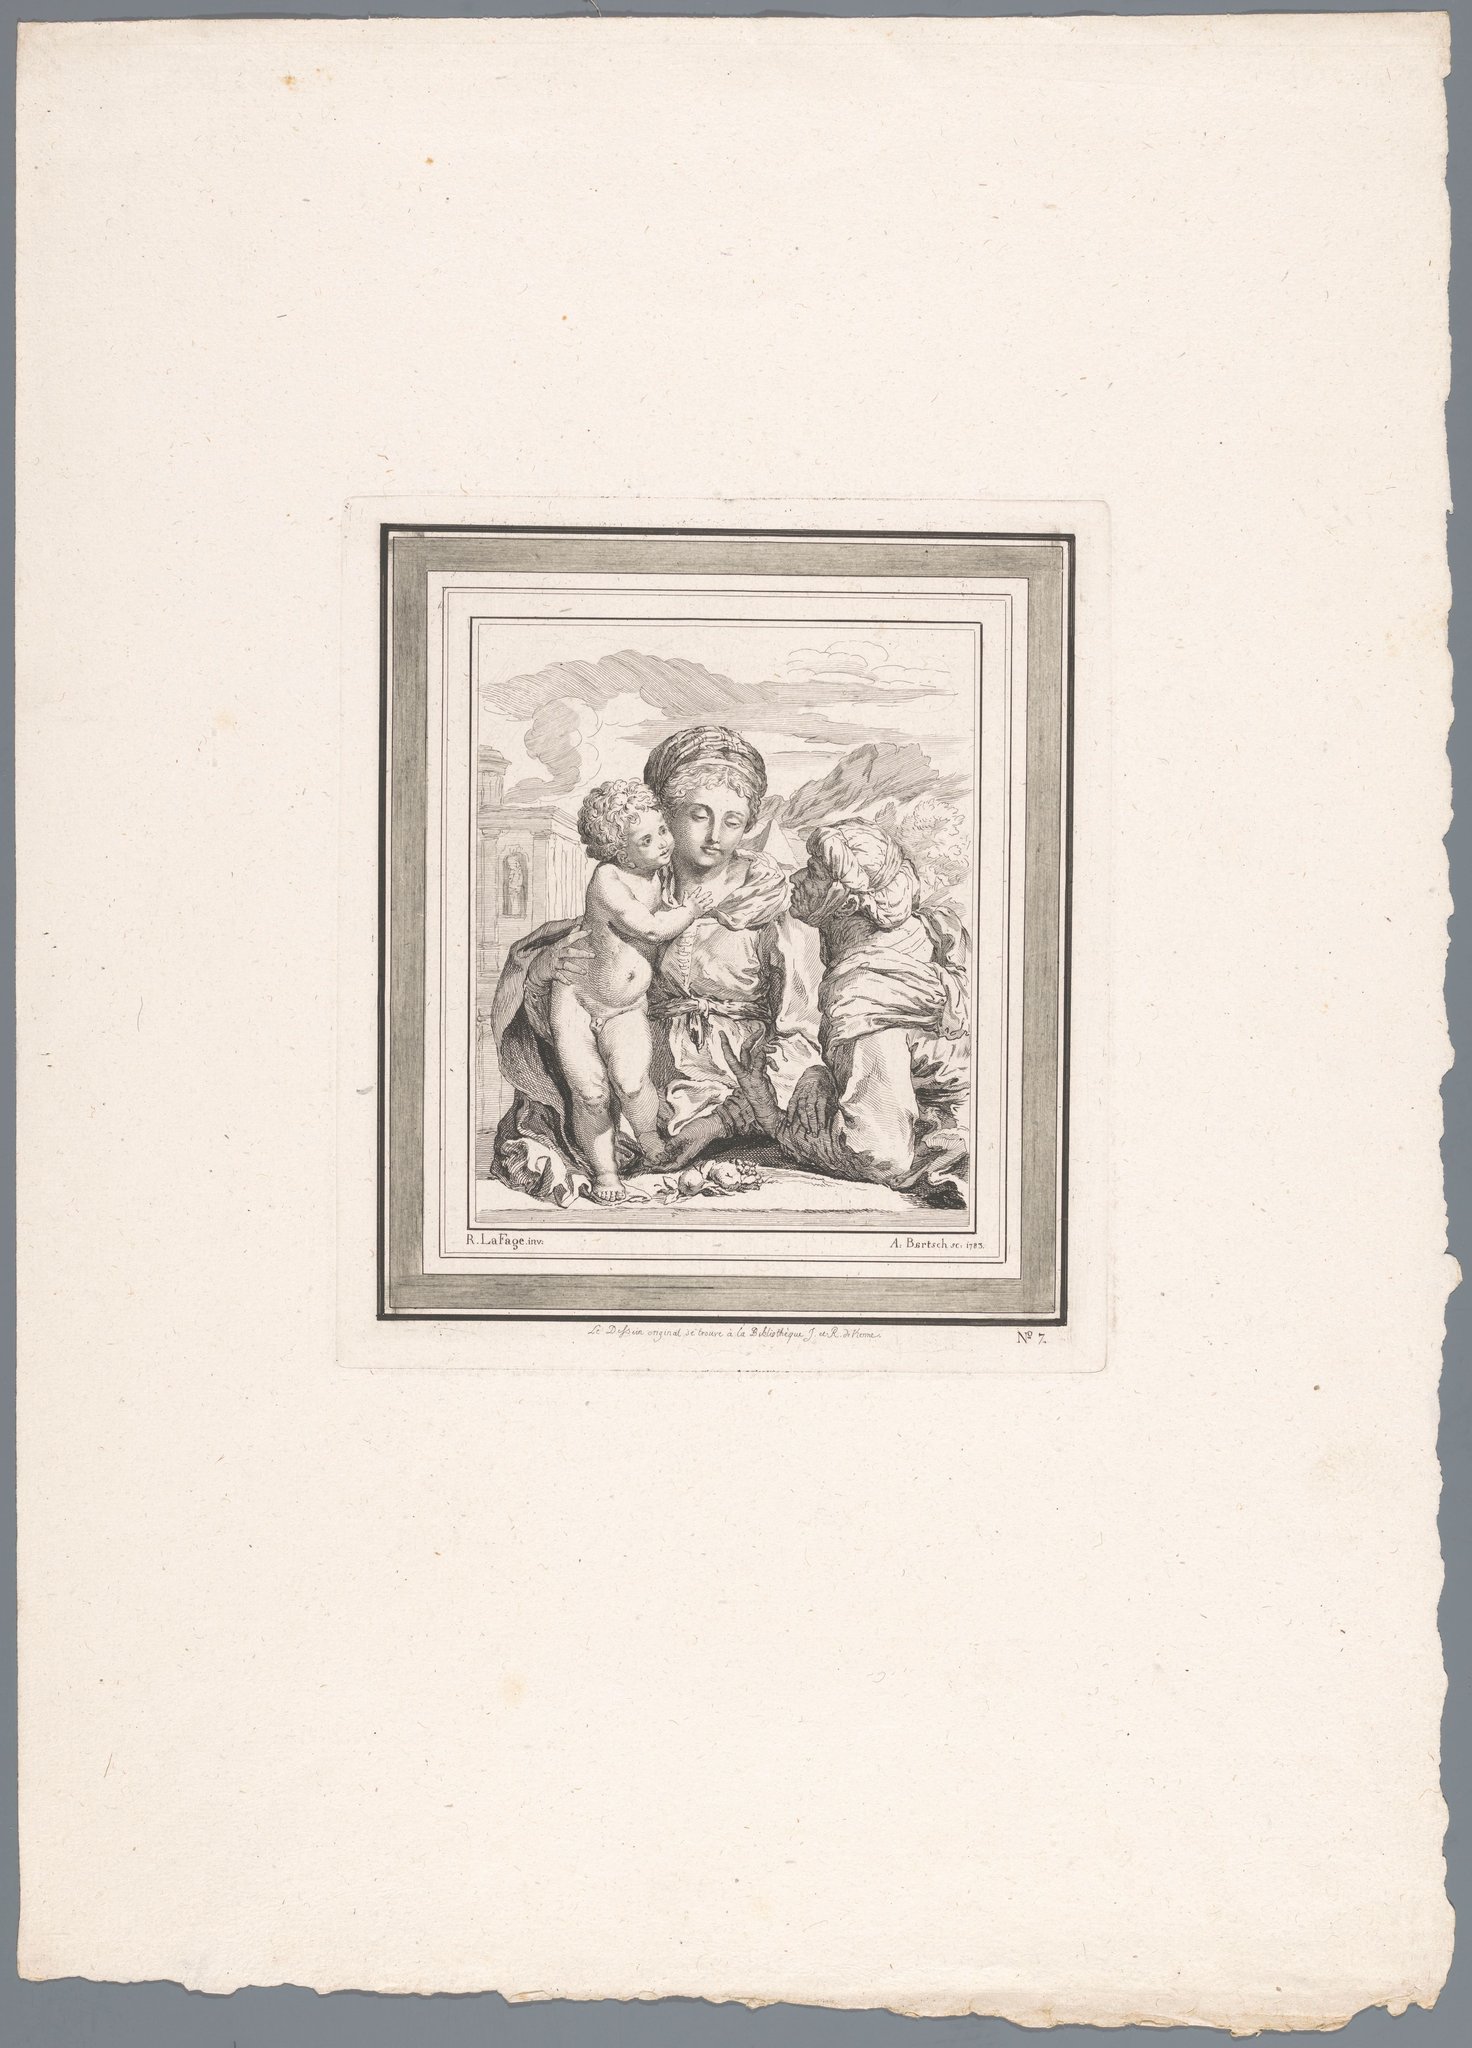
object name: print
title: Prenten naar tekeningen van Raymond de Lafage bewaard in de Hofbibliothek te Wenen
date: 1783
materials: paper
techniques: engraving, etching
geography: vienna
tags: holy family, and derived representations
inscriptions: collector's mark: Lugt 2228